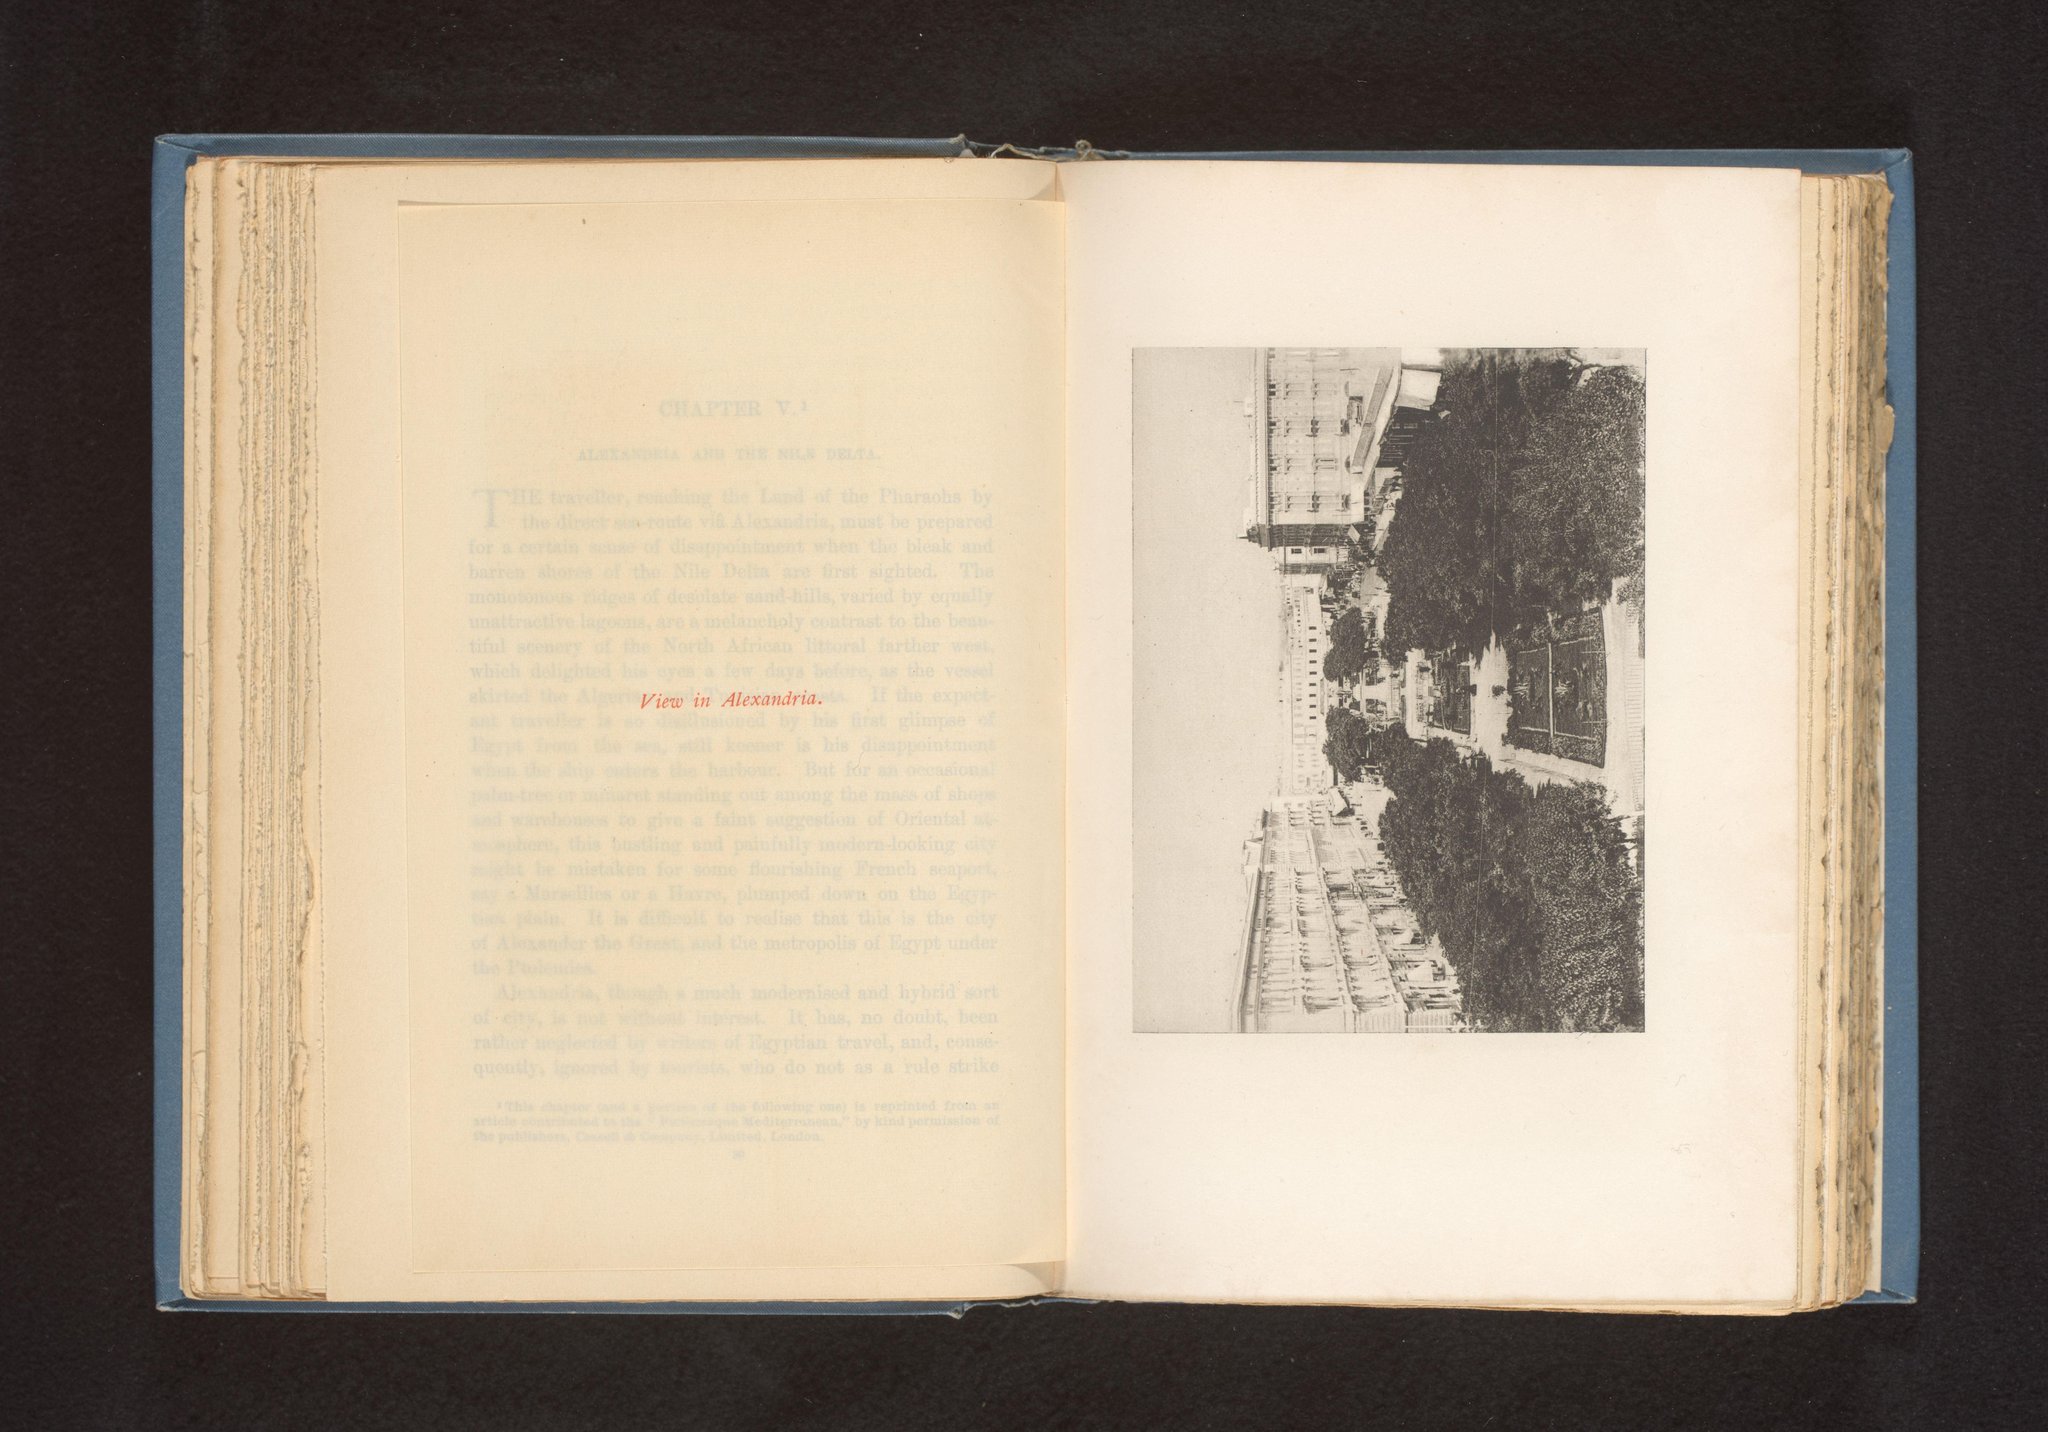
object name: photomechanical print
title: Gezicht op het Mansheya-plein te Alexandrië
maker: Anonymous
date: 1887-1897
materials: paper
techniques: photoaquatint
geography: alexandria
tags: square, place, circus, etc.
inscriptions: title: ‘View in Alexandria.’